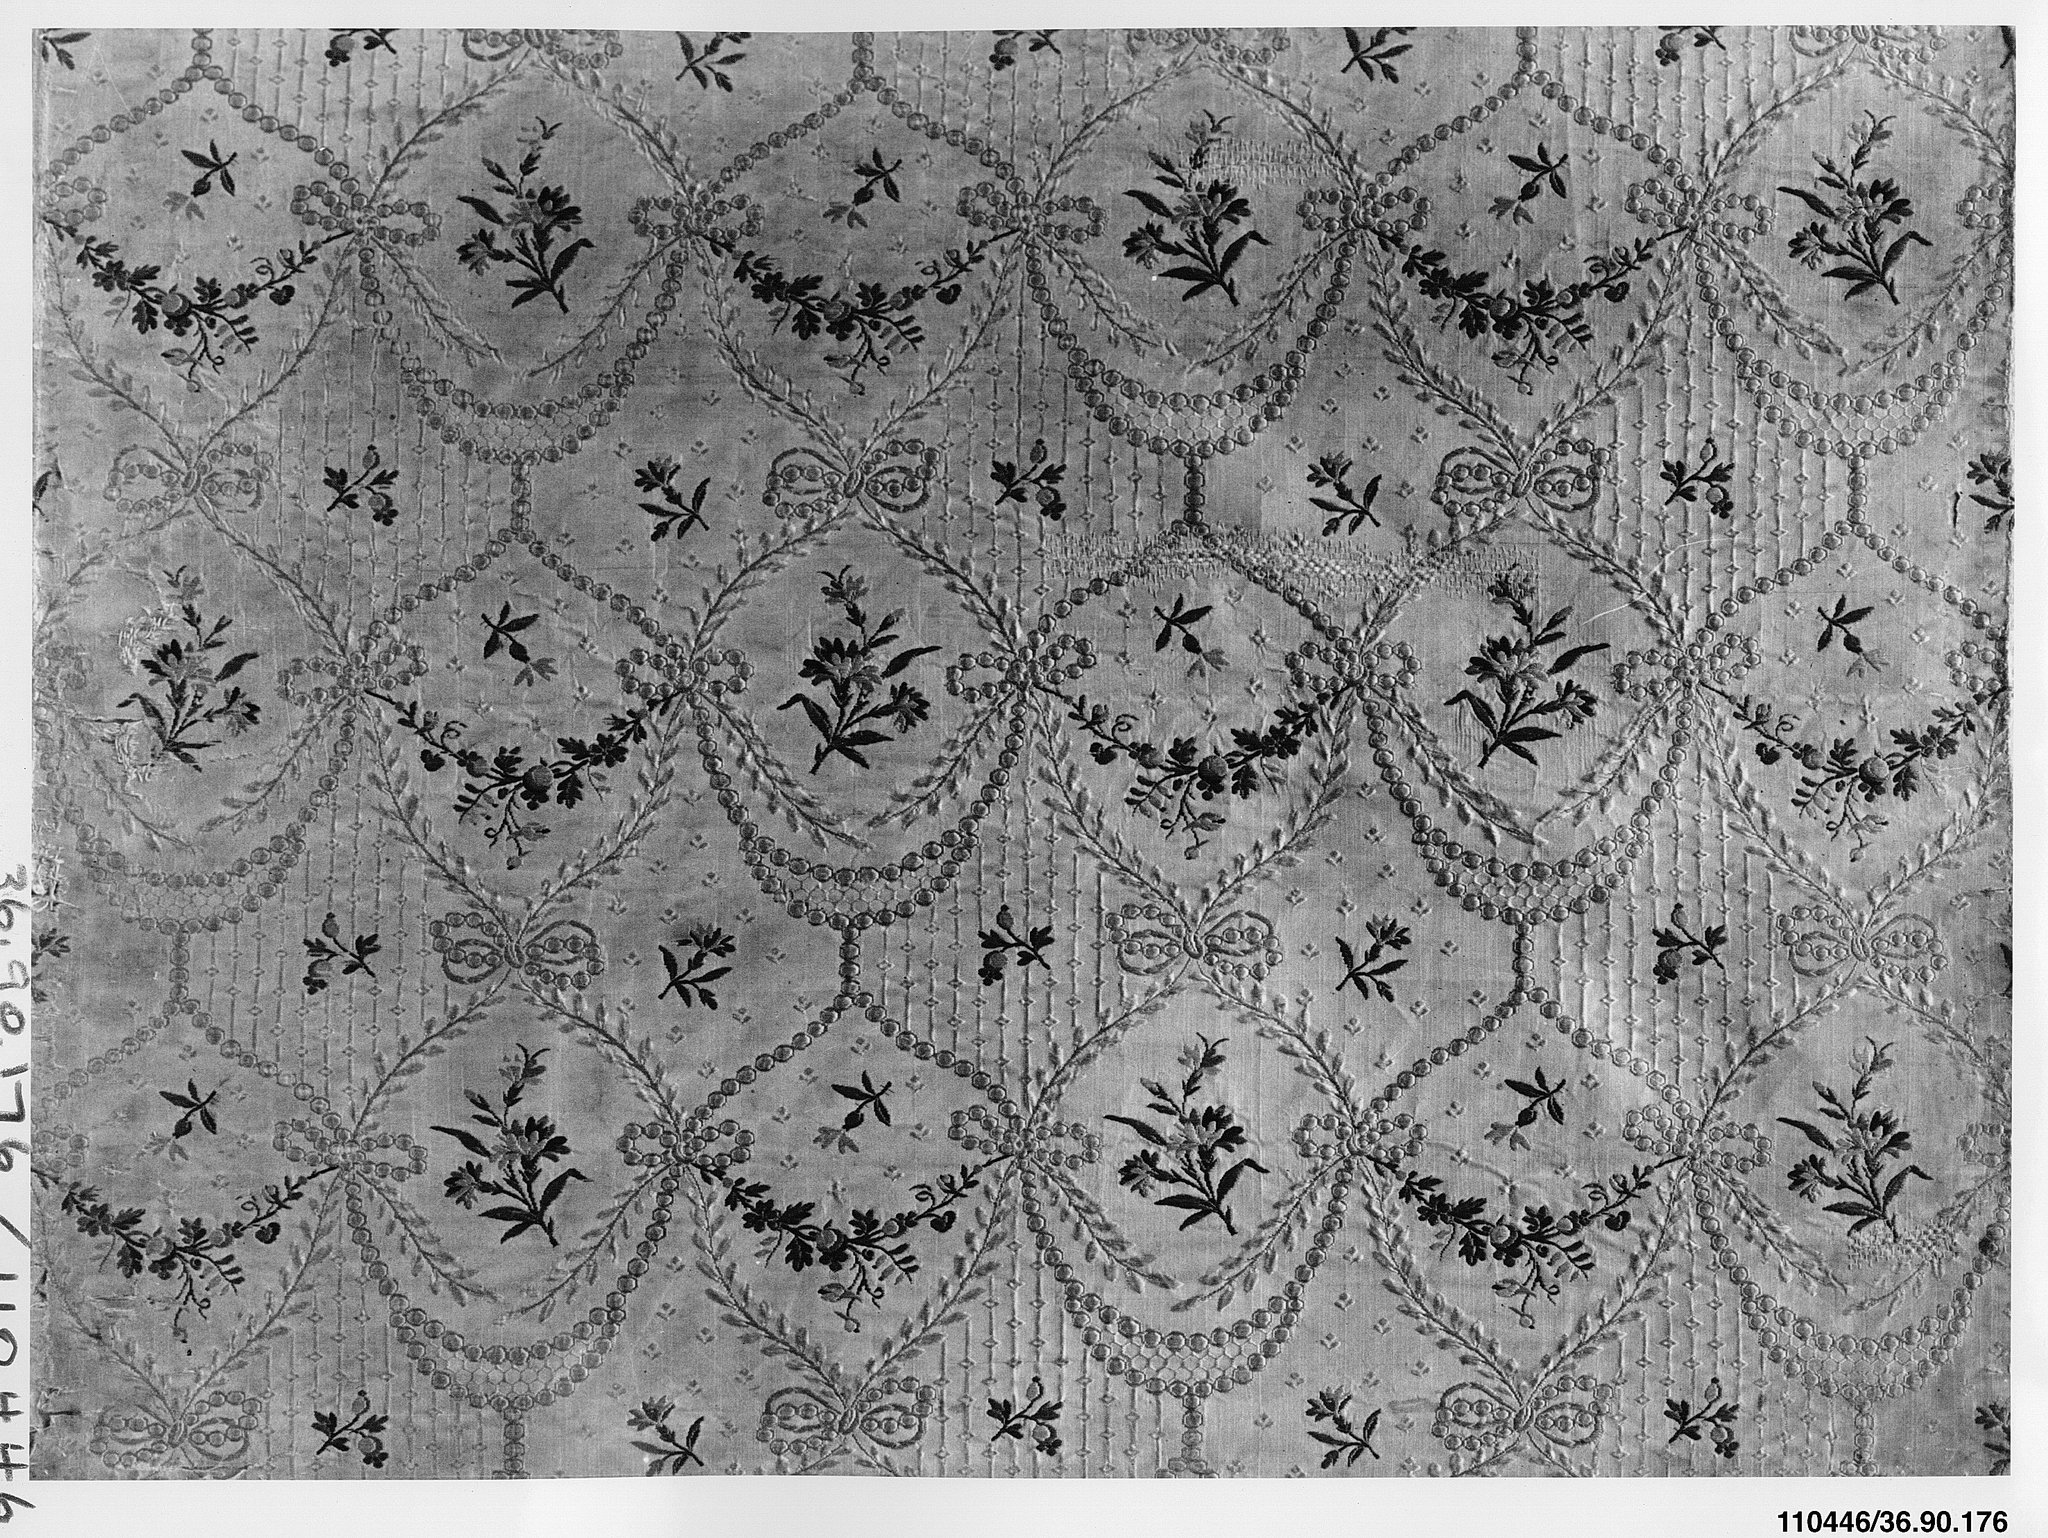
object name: piece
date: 1701-1800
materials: silk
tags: flowers,leaves